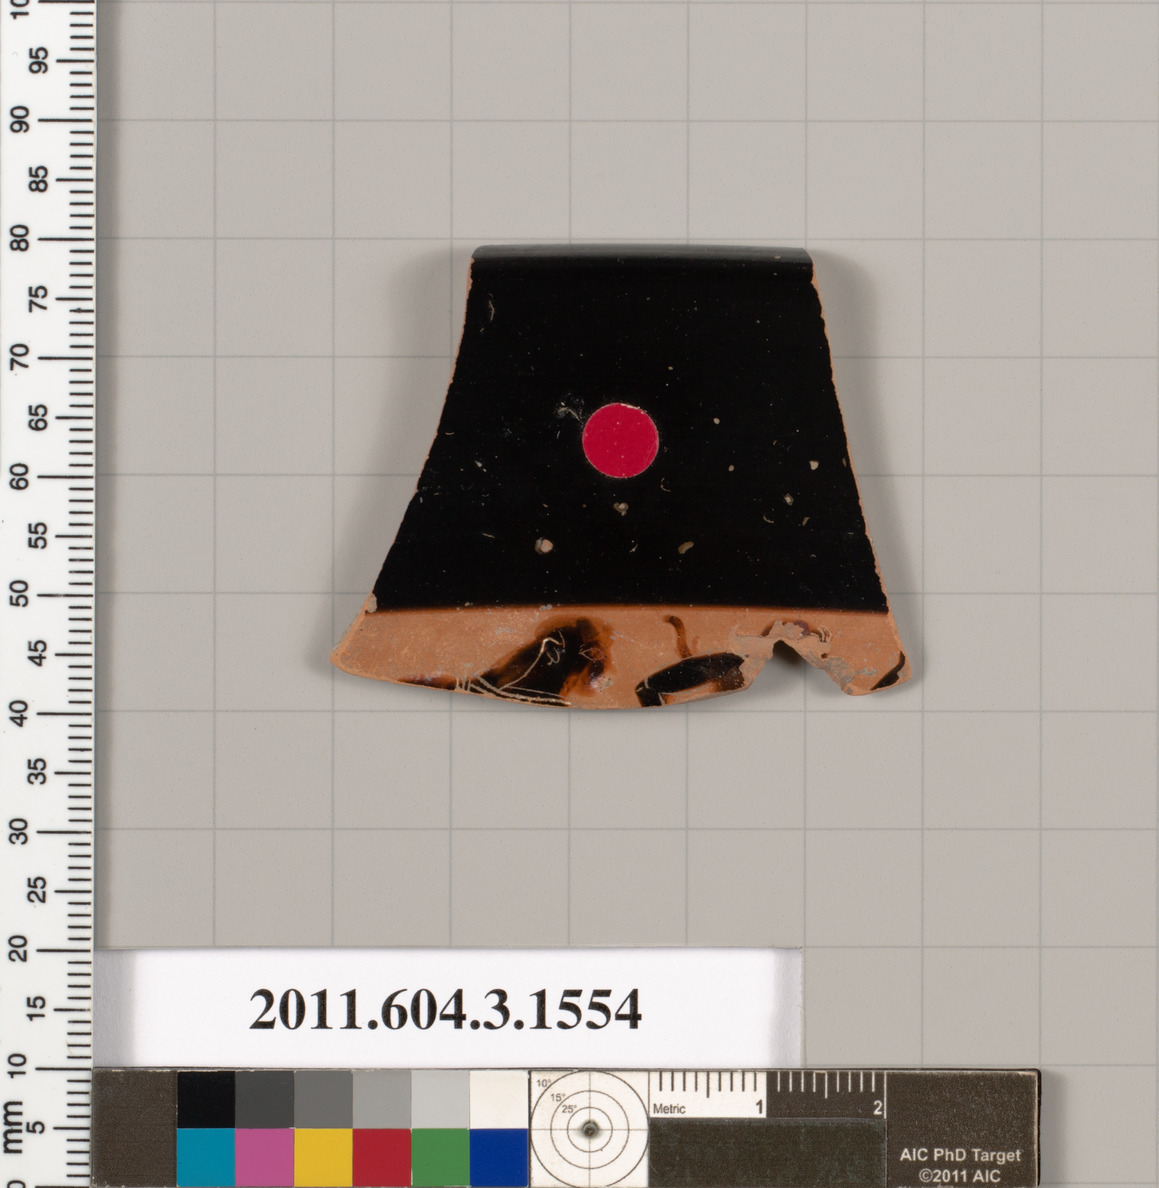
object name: kylix fragment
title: Terracotta rim fragment of a kylix: Band cup (drinking cup)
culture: greek, attic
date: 567-535 BCE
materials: terracotta